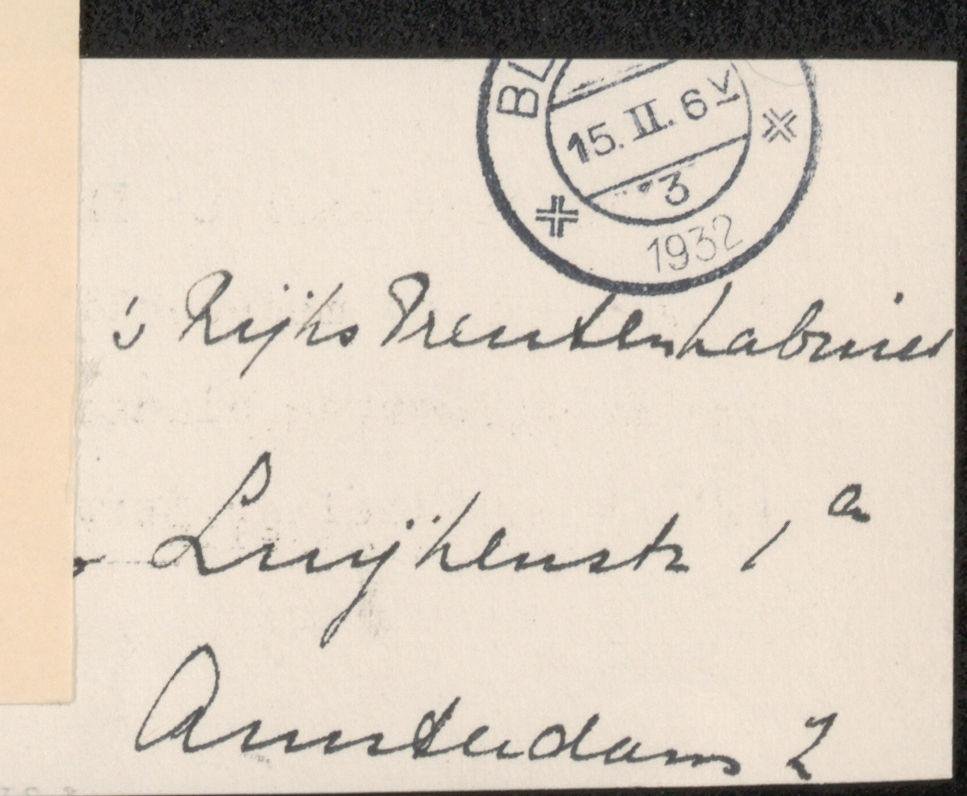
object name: postcard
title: Briefkaart aan jonkheer Hendrik Teding van Berkhout (1879-1969)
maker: herman heijenbrock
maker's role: draughtsman, painter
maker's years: 1871-1948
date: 1932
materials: cardboard, ink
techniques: pen, writing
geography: blaricum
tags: print room, haarlem, amsterdam, jonkheer hendrik teding van berkhout (1879-1969), drawing, the graphic arts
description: Briefkaart bevat briefkaart betreffende teruggezonden werken.